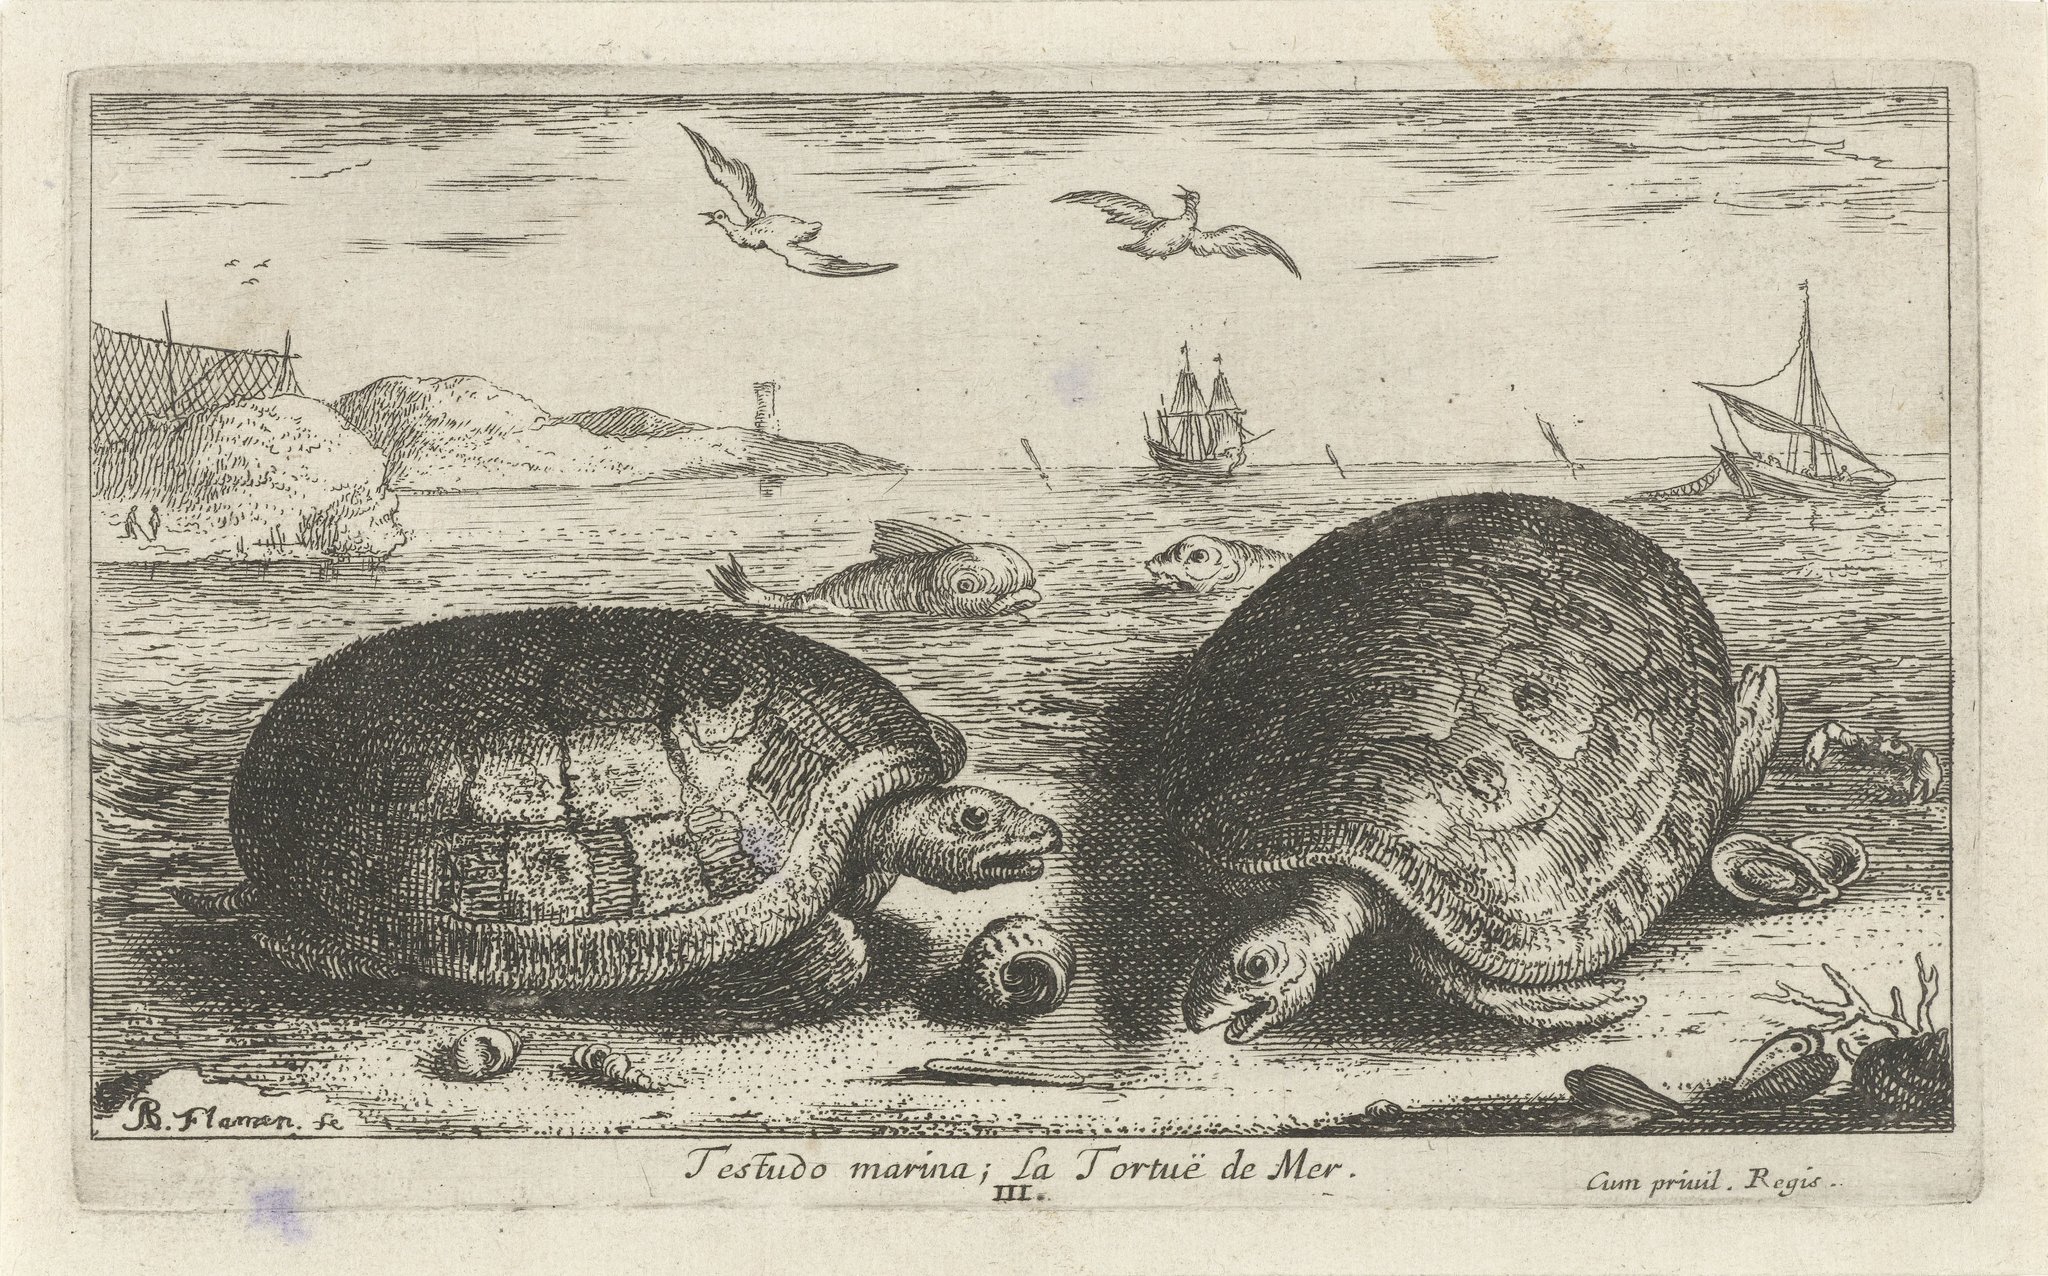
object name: print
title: Vissen en andere zeedieren - zoutwater tweede reeks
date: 1664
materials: paper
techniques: etching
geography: paris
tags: tortoises, turtles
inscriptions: collector's mark: Lugt 2228, collector's mark: Lugt 1490